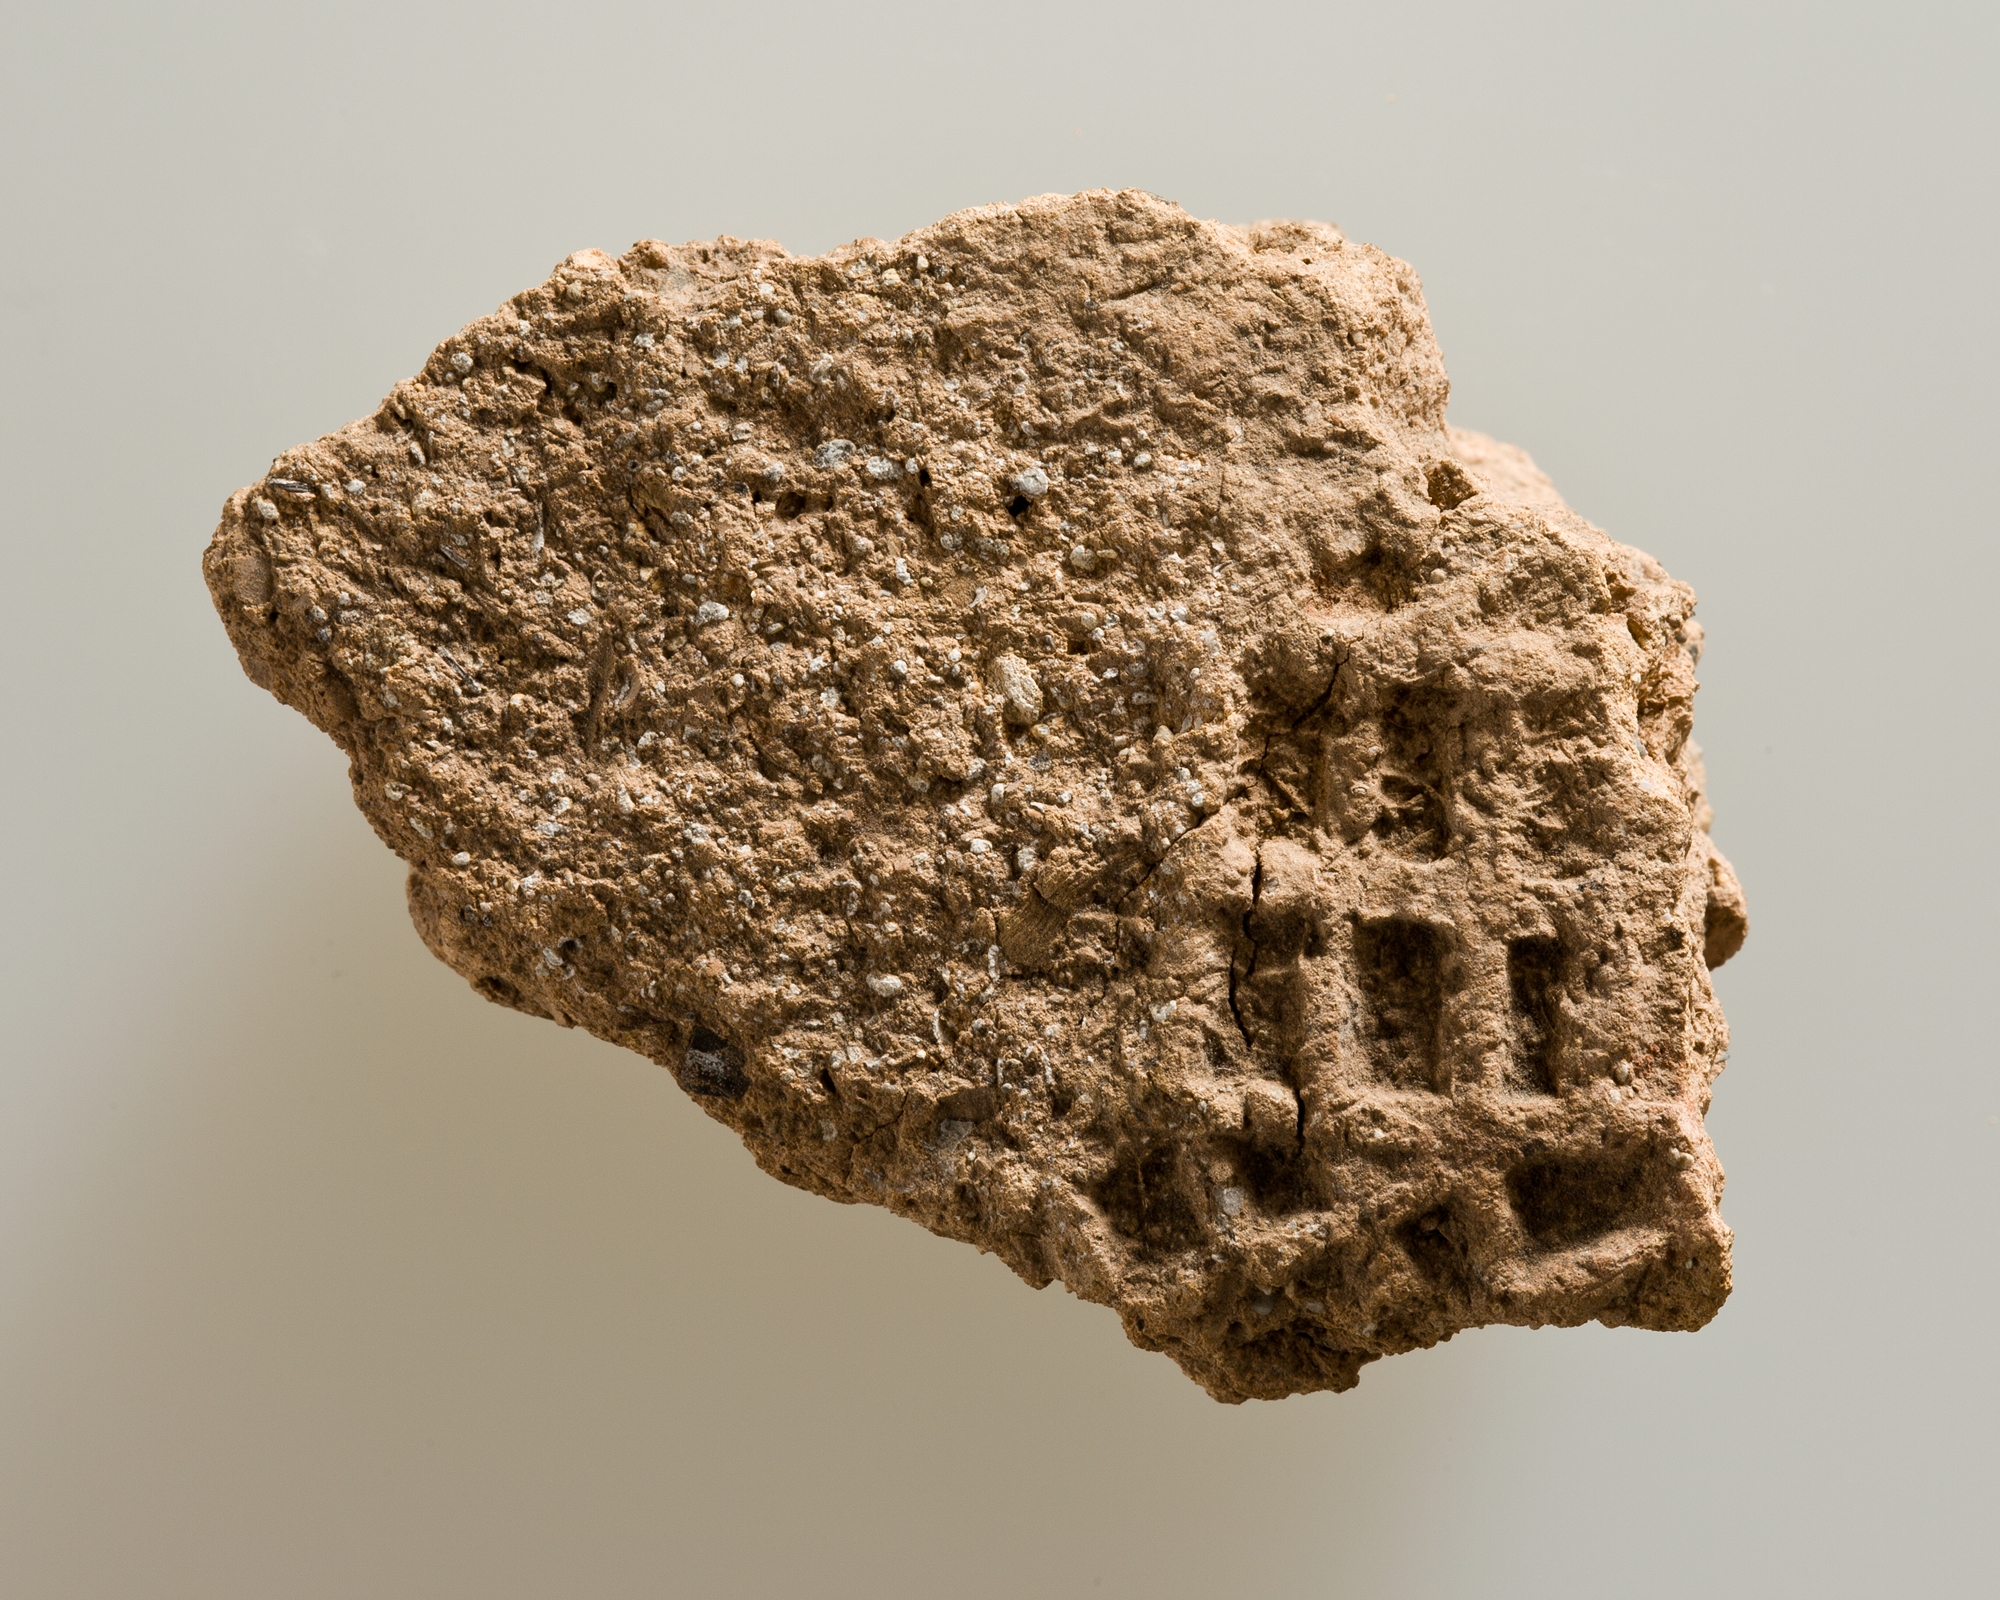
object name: sealing, jar, neithhotep, hetepneith, menes, menesgrab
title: Jar sealing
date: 2960-2649 BCE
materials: clay, mud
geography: egypt